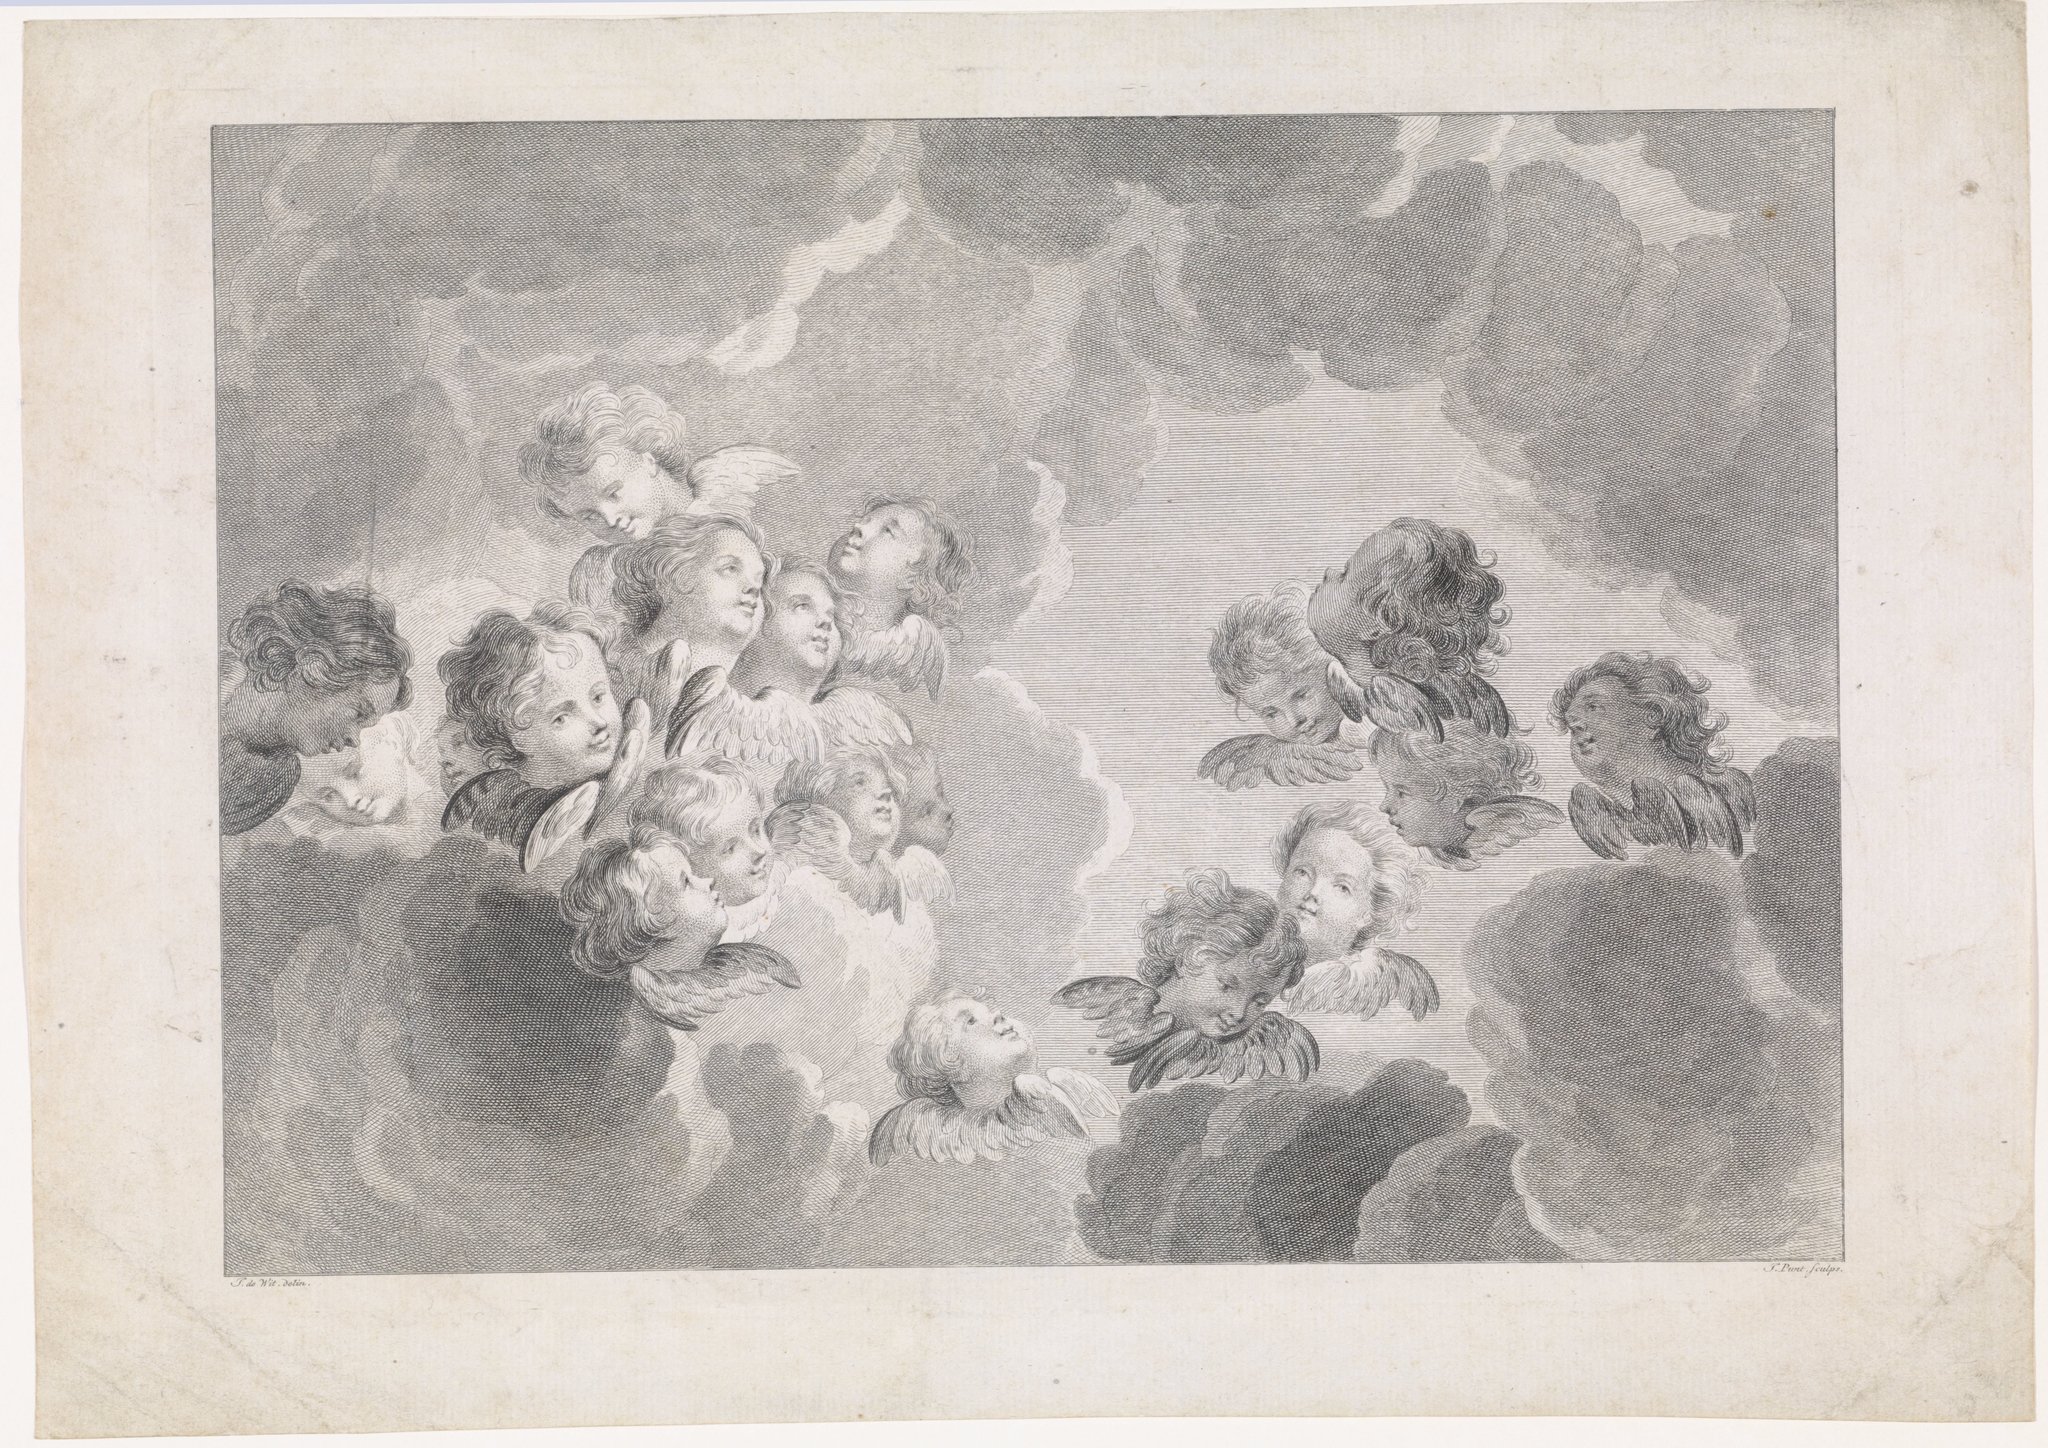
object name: print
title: Cherubijnen in de wolken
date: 1731-1779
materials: paper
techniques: engraving, etching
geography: amsterdam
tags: cherubs, i.e. children's heads with wings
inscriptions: collector's mark: Lugt 2228